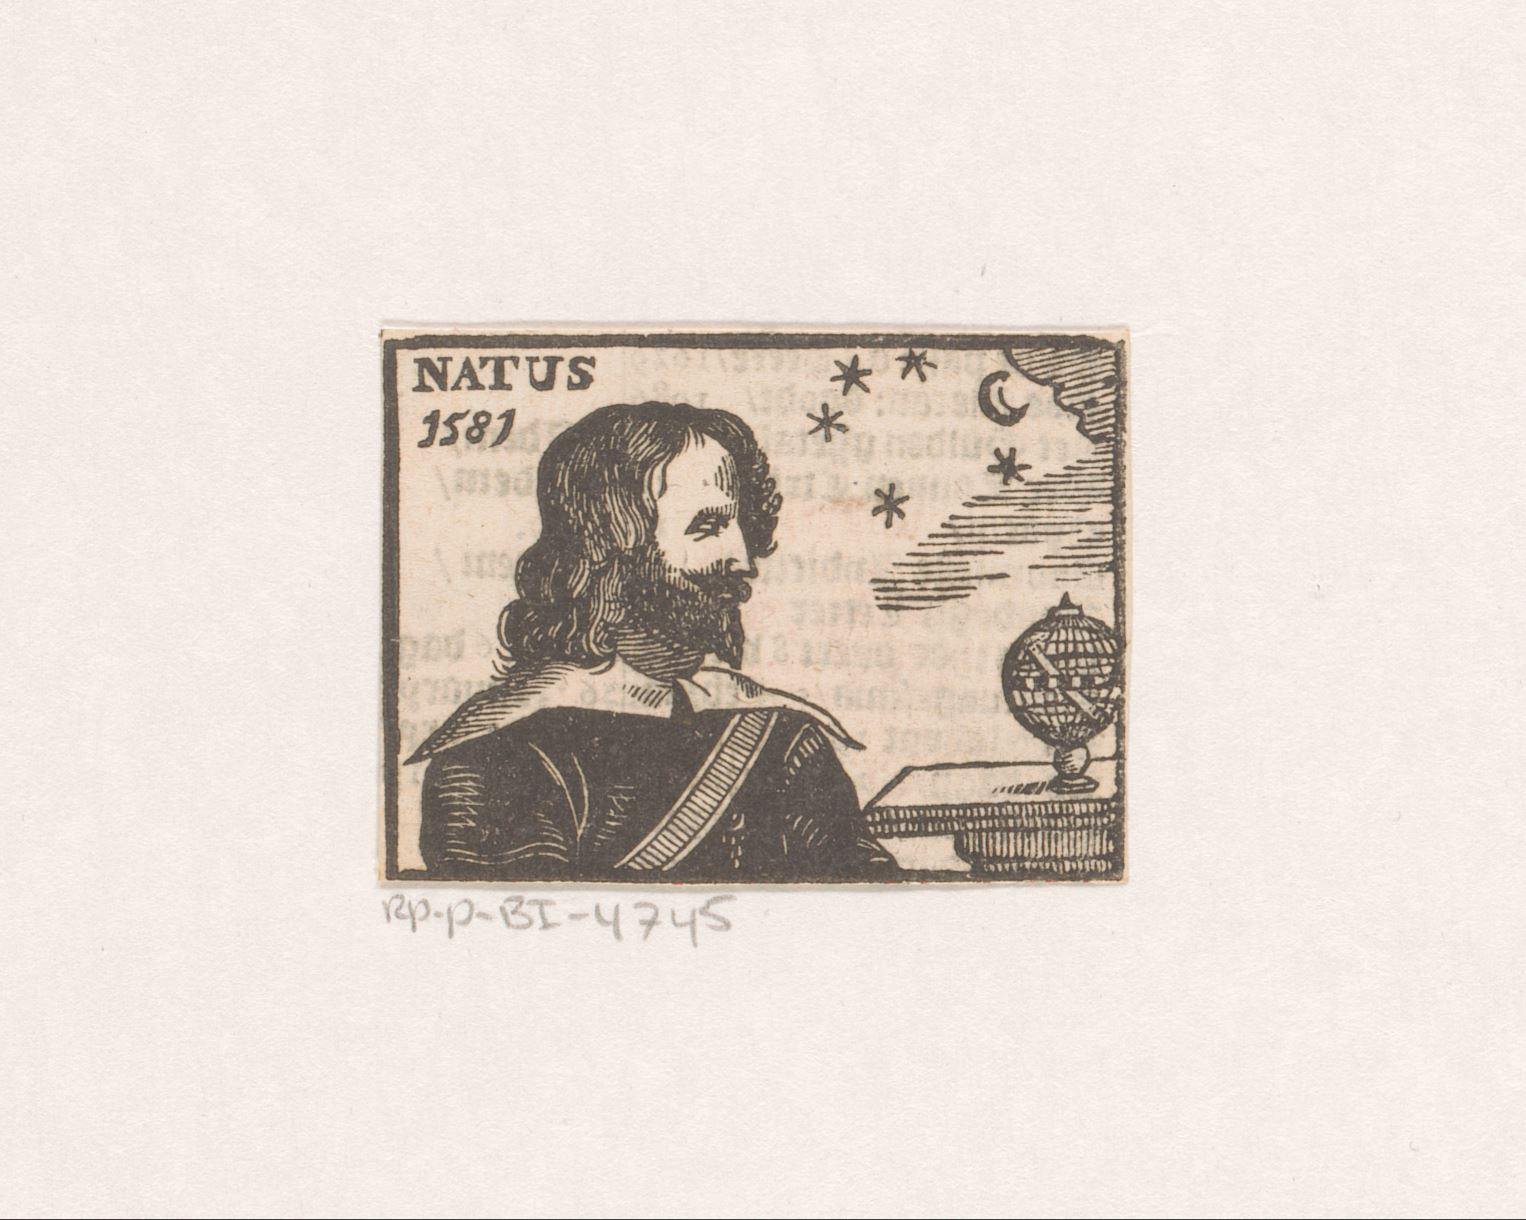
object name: print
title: Portret van een astronoom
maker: Anonymous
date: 1600-1699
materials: paper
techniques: letterpress printing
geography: netherlands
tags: astronomy (and cosmography) (+ portrait of scholar, scientist), astronomical instruments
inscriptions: collector's mark: Lugt 240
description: Portret van een astronoom. Op de achtergrond sterren, de maan en een hemelglobe (armillarium). Linksboven zijn geboortejaar.